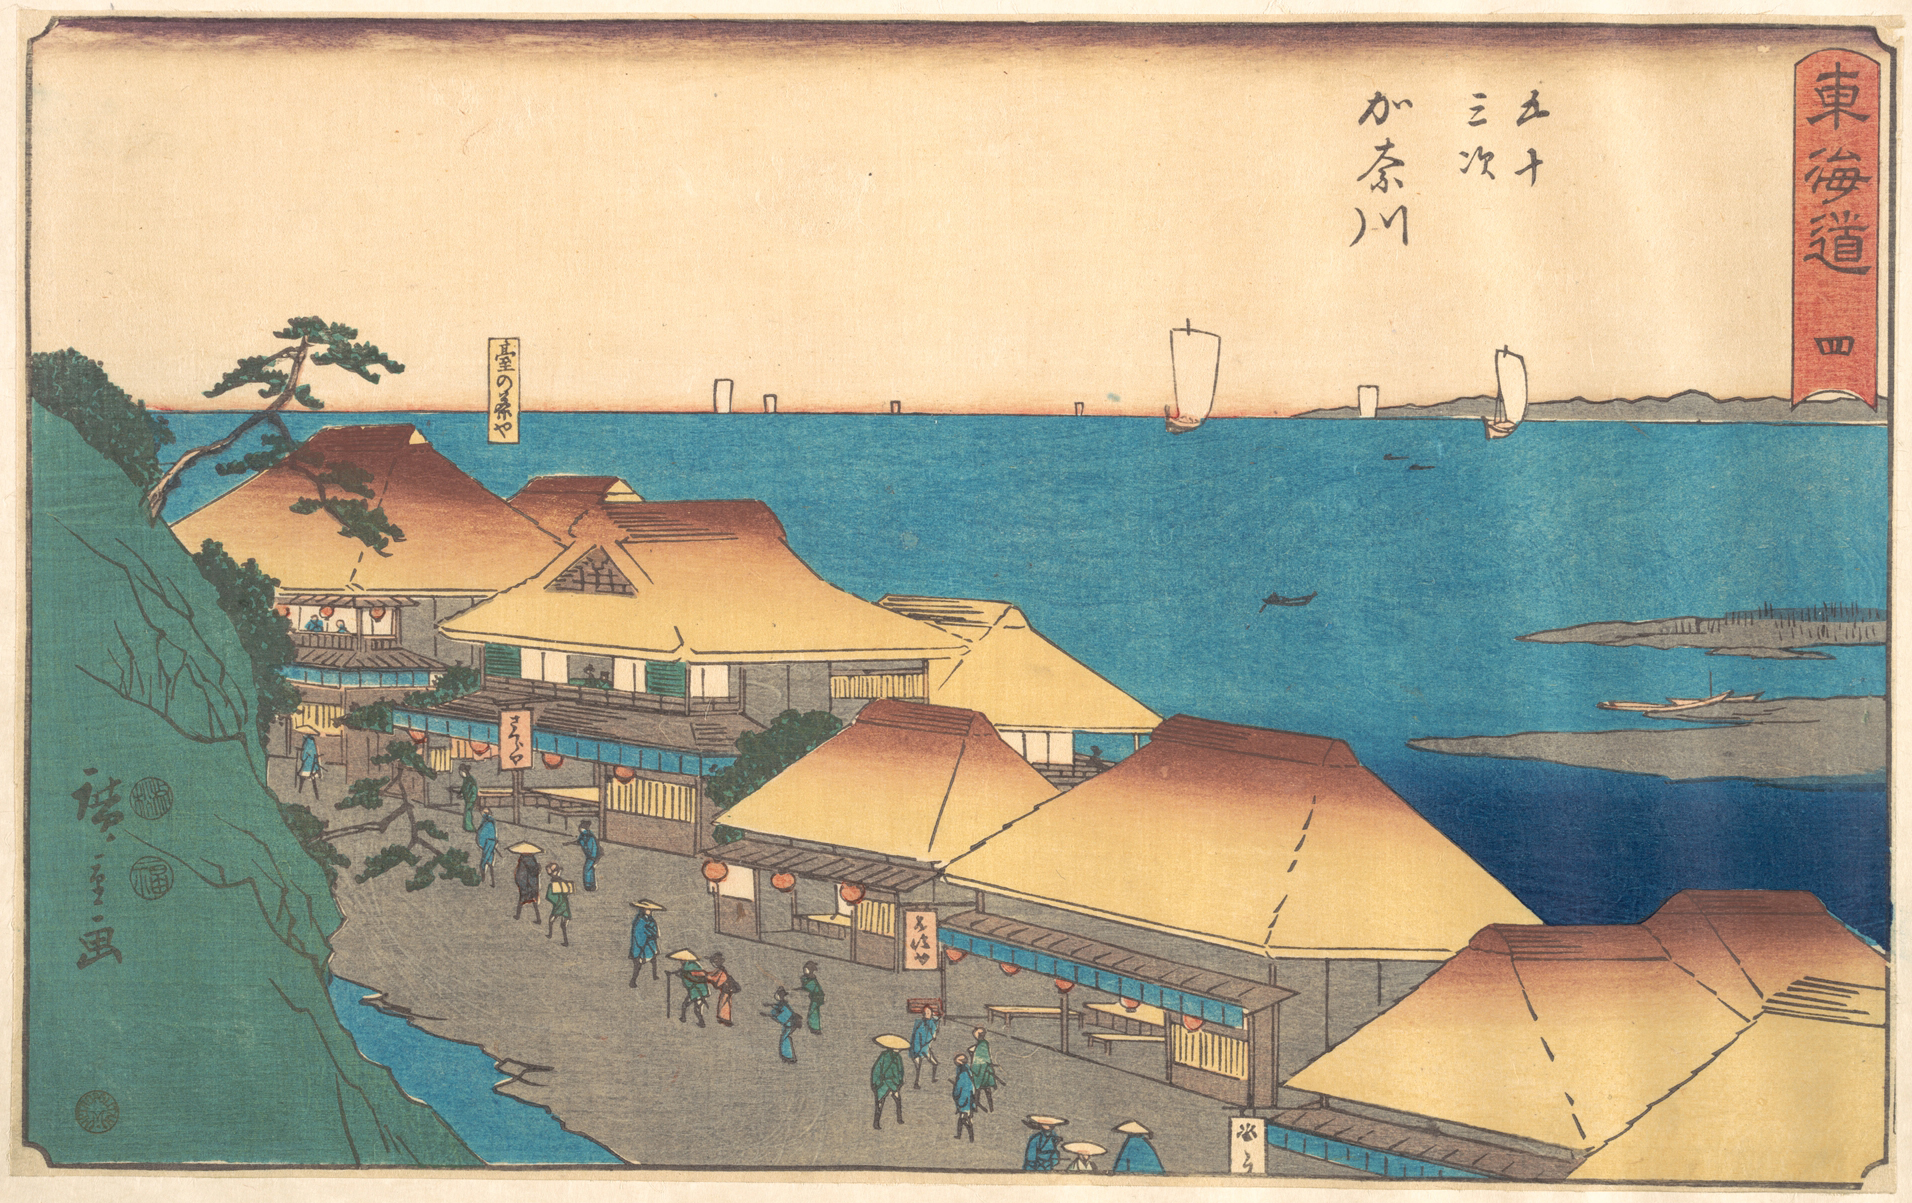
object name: print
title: Kanagawa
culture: japanese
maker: utagawa hiroshige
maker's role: artist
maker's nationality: japanese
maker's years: 1797-1858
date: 1840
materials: ink, paper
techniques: woodblock print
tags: boats,tea houses